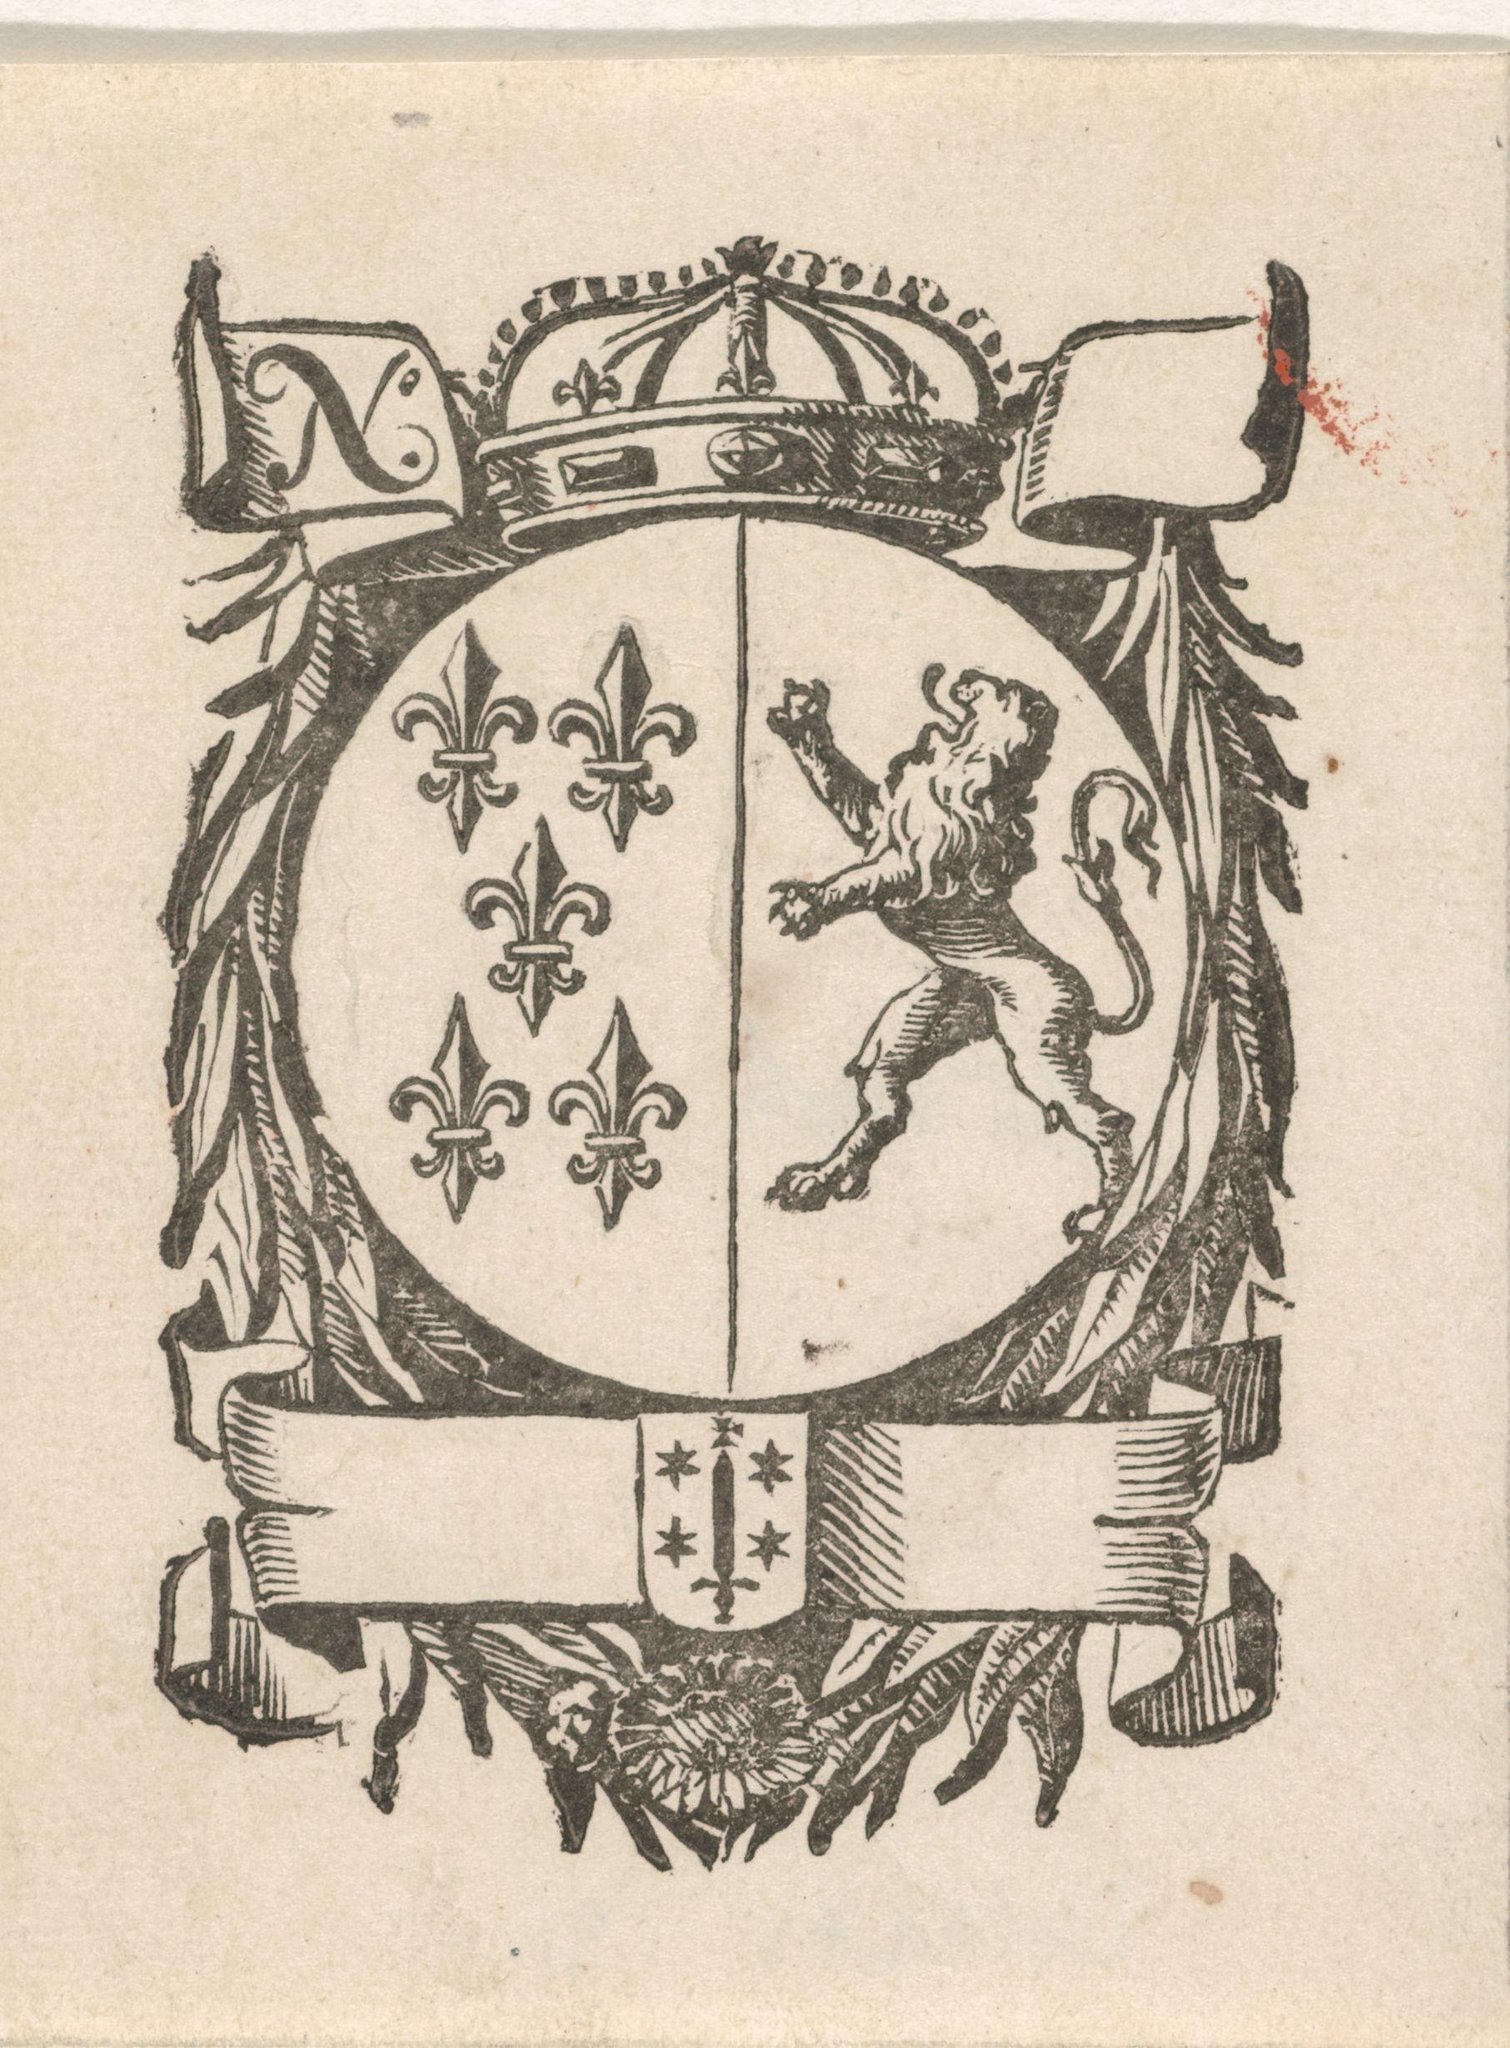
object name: handelsetiket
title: Handelsetiket van Claes Tetrode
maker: isaac vincentsz. van der vinne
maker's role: draughtsman, print maker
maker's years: 1665-1740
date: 1681-1740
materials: paper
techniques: woodcut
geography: haarlem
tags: coat of arms (as symbol of the state, etc.), coat of arms (as symbol of the state, etc.) (+ city; municipal), crown (symbol of sovereignty), vignette, haarlem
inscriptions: collector's mark: Lugt 240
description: Wapen in een ovaal van bladeren. Midden boven een kroon. Midden onder het wapen van de stad Haarlem.